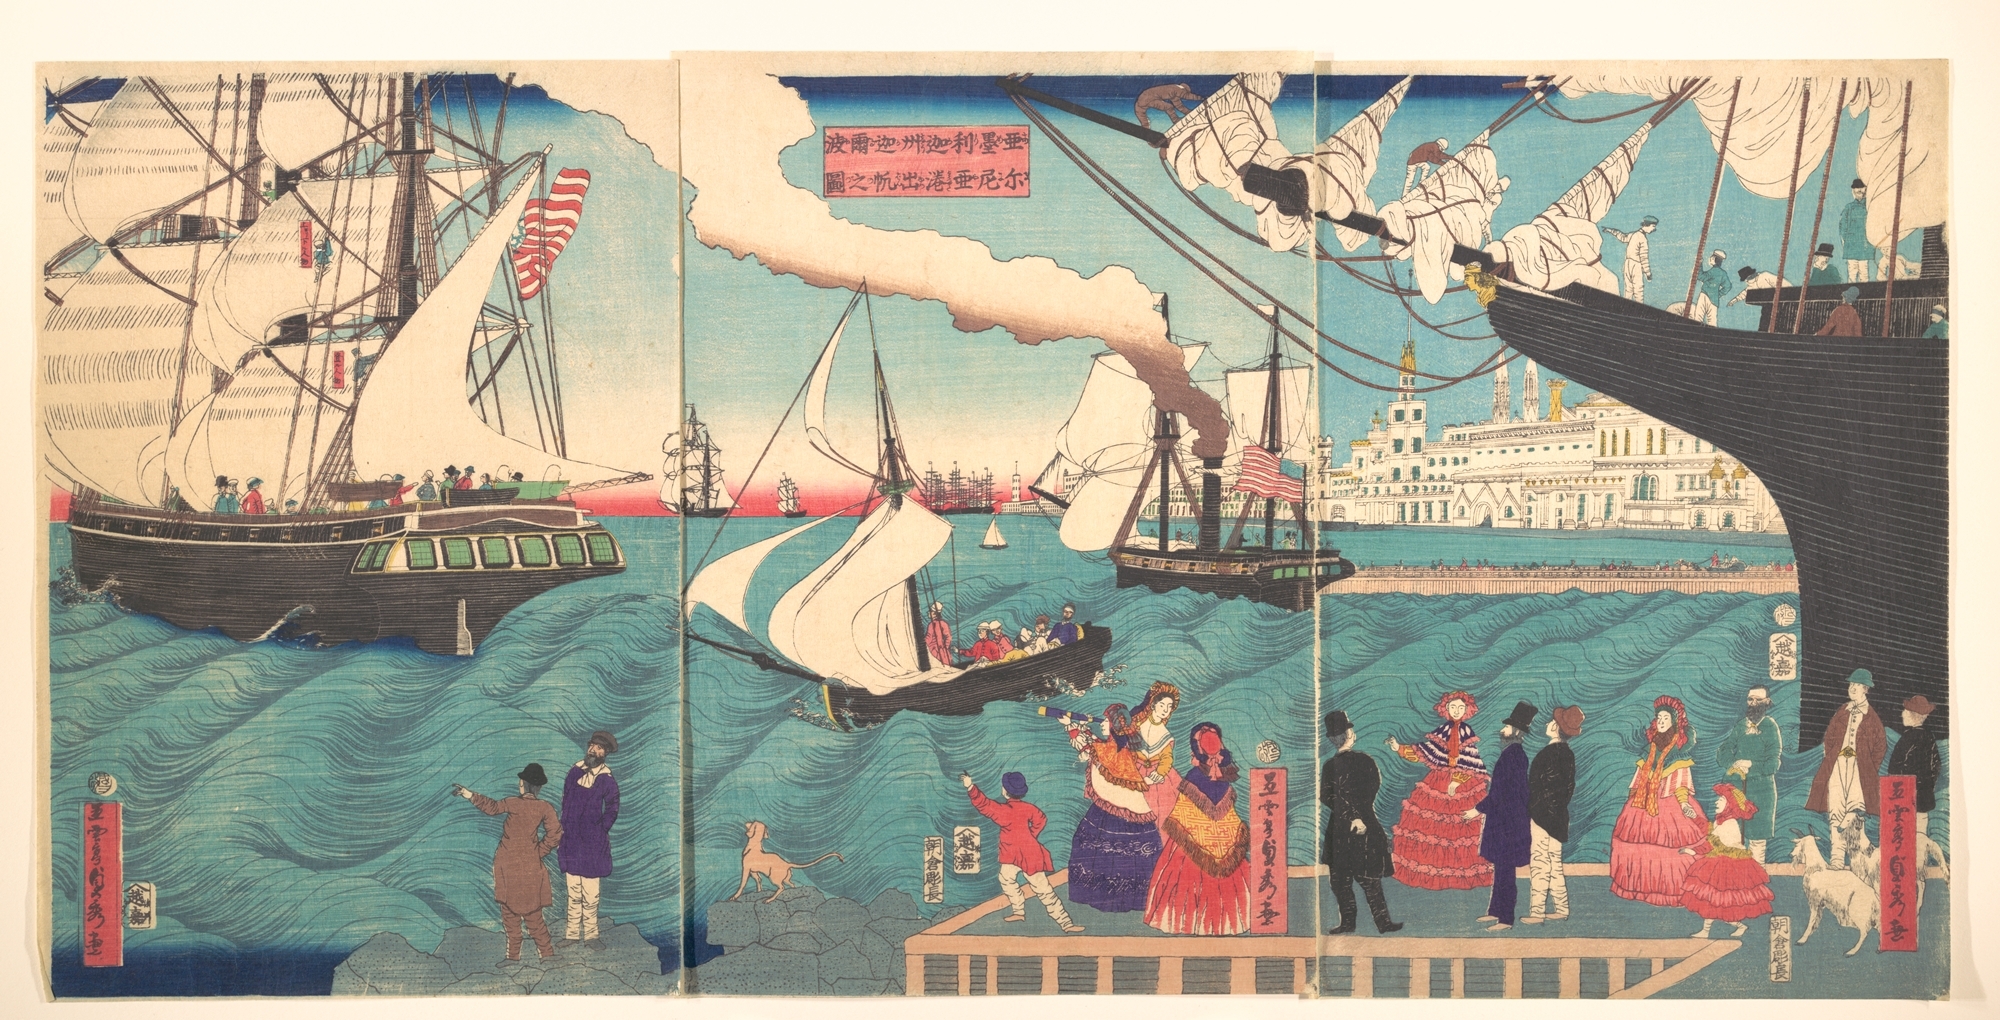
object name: print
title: Vessels Departing from California, America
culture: japanese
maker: utagawa (gountei) sadahide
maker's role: artist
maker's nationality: japanese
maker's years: 1807-1873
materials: ink, paper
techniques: woodblock print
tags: men,women,waves,ships